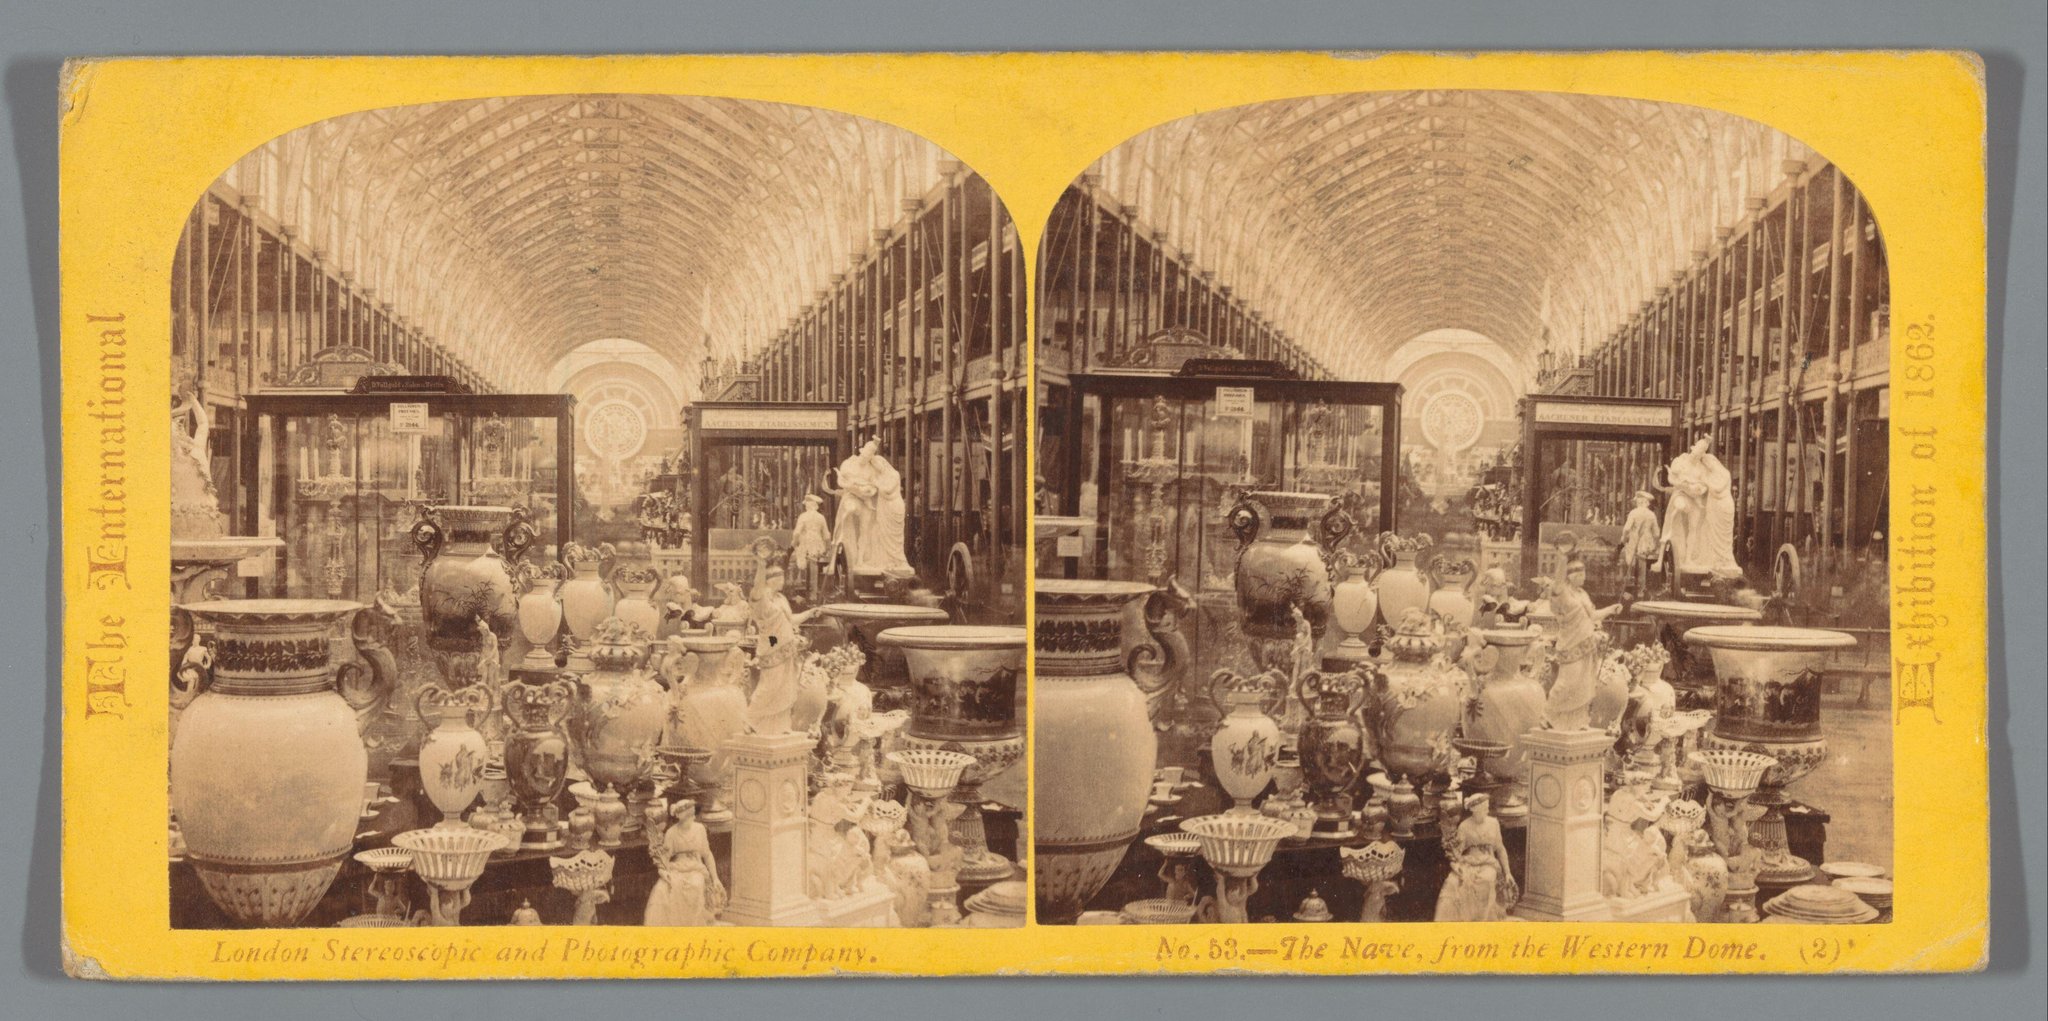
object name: stereograph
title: The Nave from the Western Dome (2)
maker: william england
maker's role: fotograaf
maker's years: 1816-1896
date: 1862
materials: cardboard, paper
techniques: albumen print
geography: london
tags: world fair, world exhibition, london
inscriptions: inscription: ‘59’, number: ‘No. 53.’